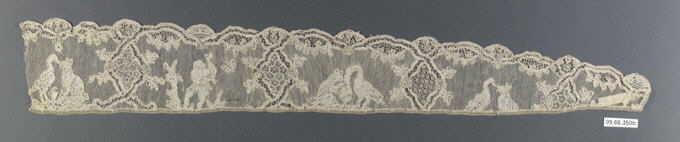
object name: piece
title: Piece (one of three)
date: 1701-1800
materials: lace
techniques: lace